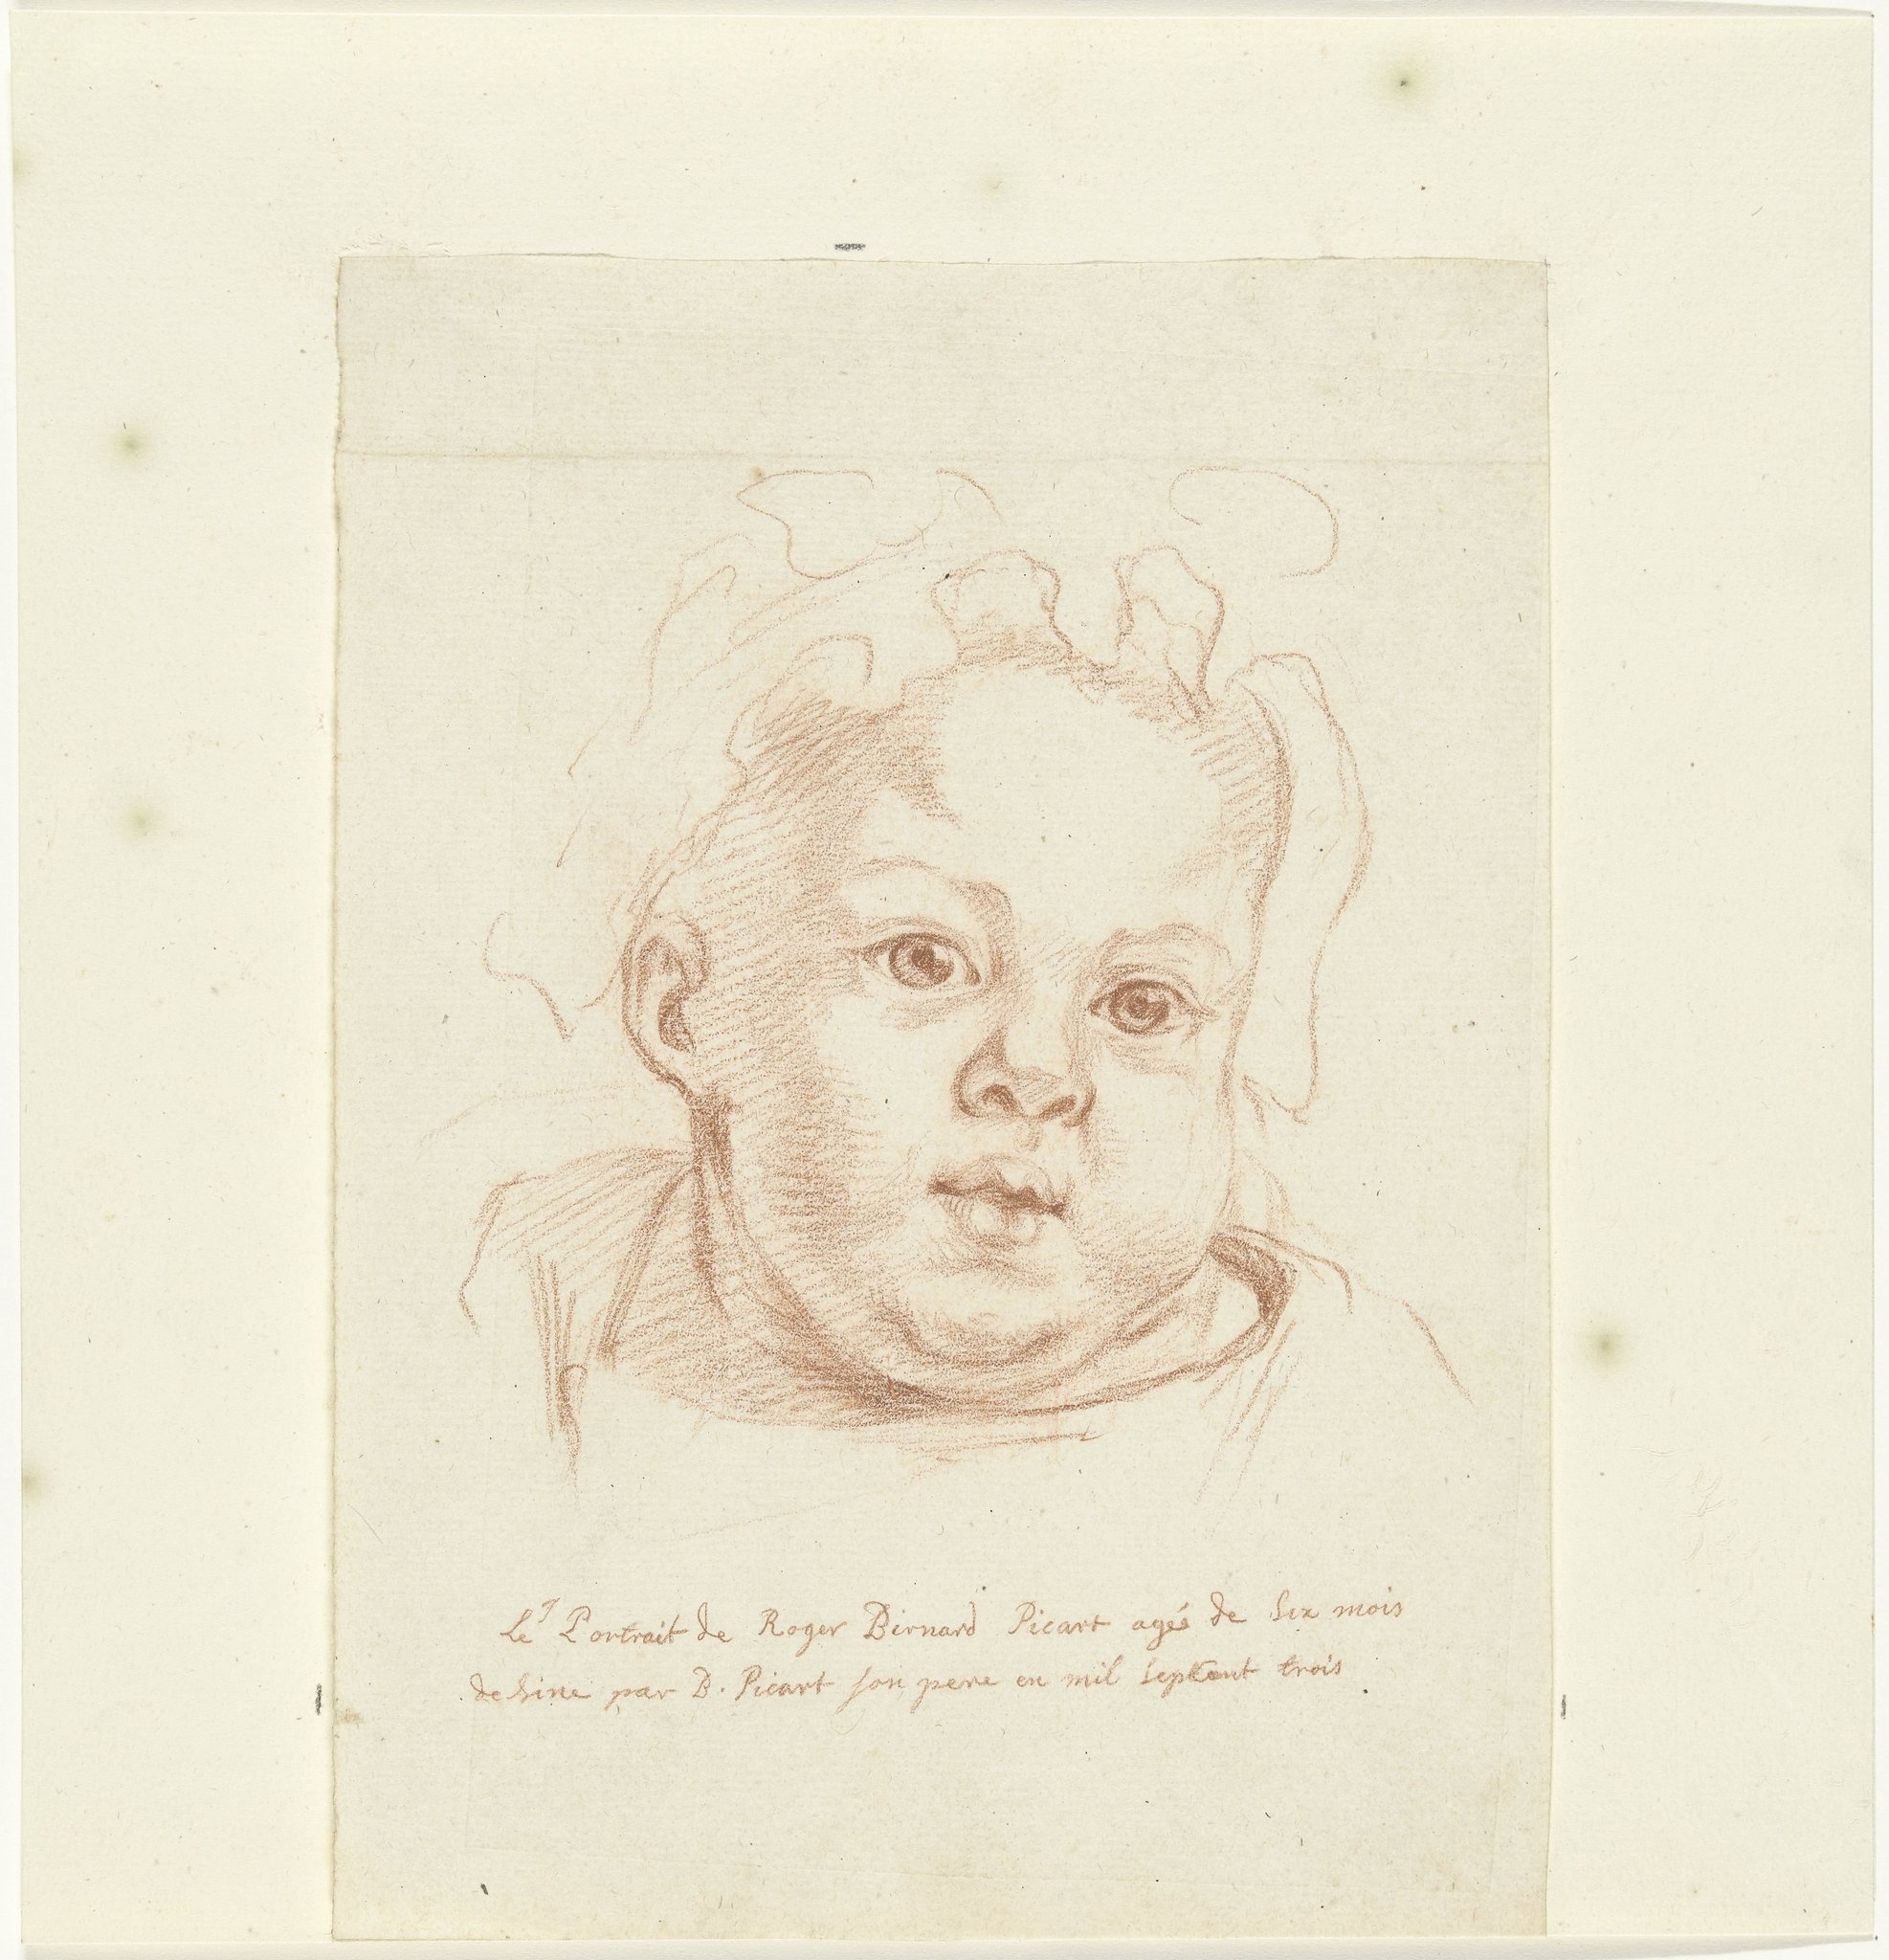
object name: drawing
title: Portret van Roger Bernard Picart, oud zes maanden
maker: bernard picart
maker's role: draughtsman, print maker, publisher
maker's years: 1673-1733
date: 1703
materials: chalk, paper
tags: historical persons, infant, baby